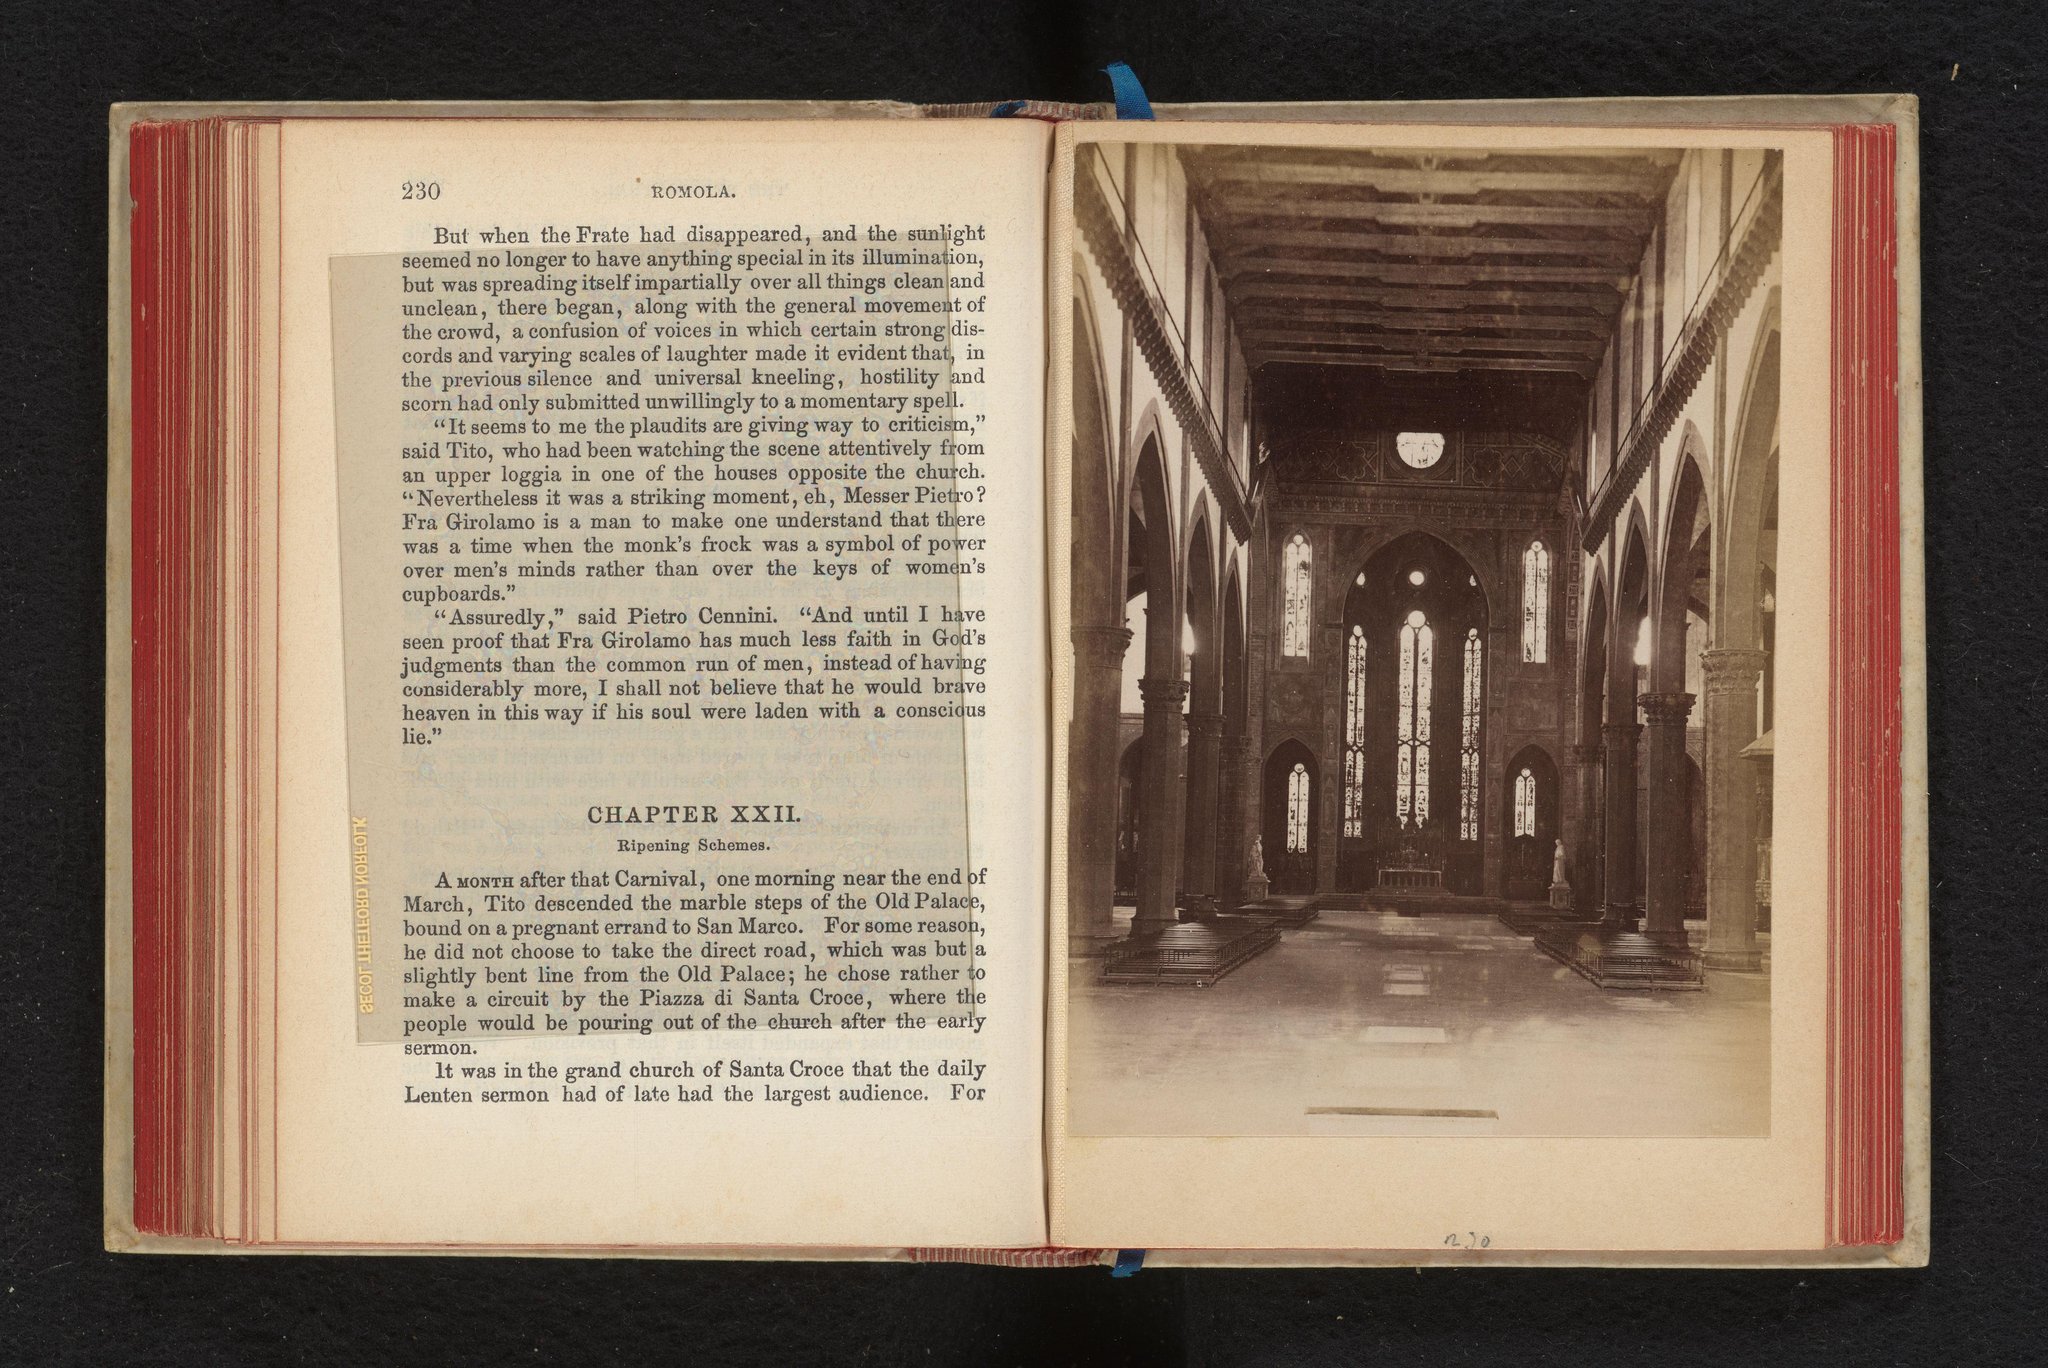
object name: page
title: Interieur van de Santa Croce, Florence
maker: giacomo brogi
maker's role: fotograaf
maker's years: 1822-1881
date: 1858-1863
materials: paper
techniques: albumen print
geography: florence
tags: interior of church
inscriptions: name: ‘Brogi’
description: Foto op ongenummerde pagina tegenover pagina 230.